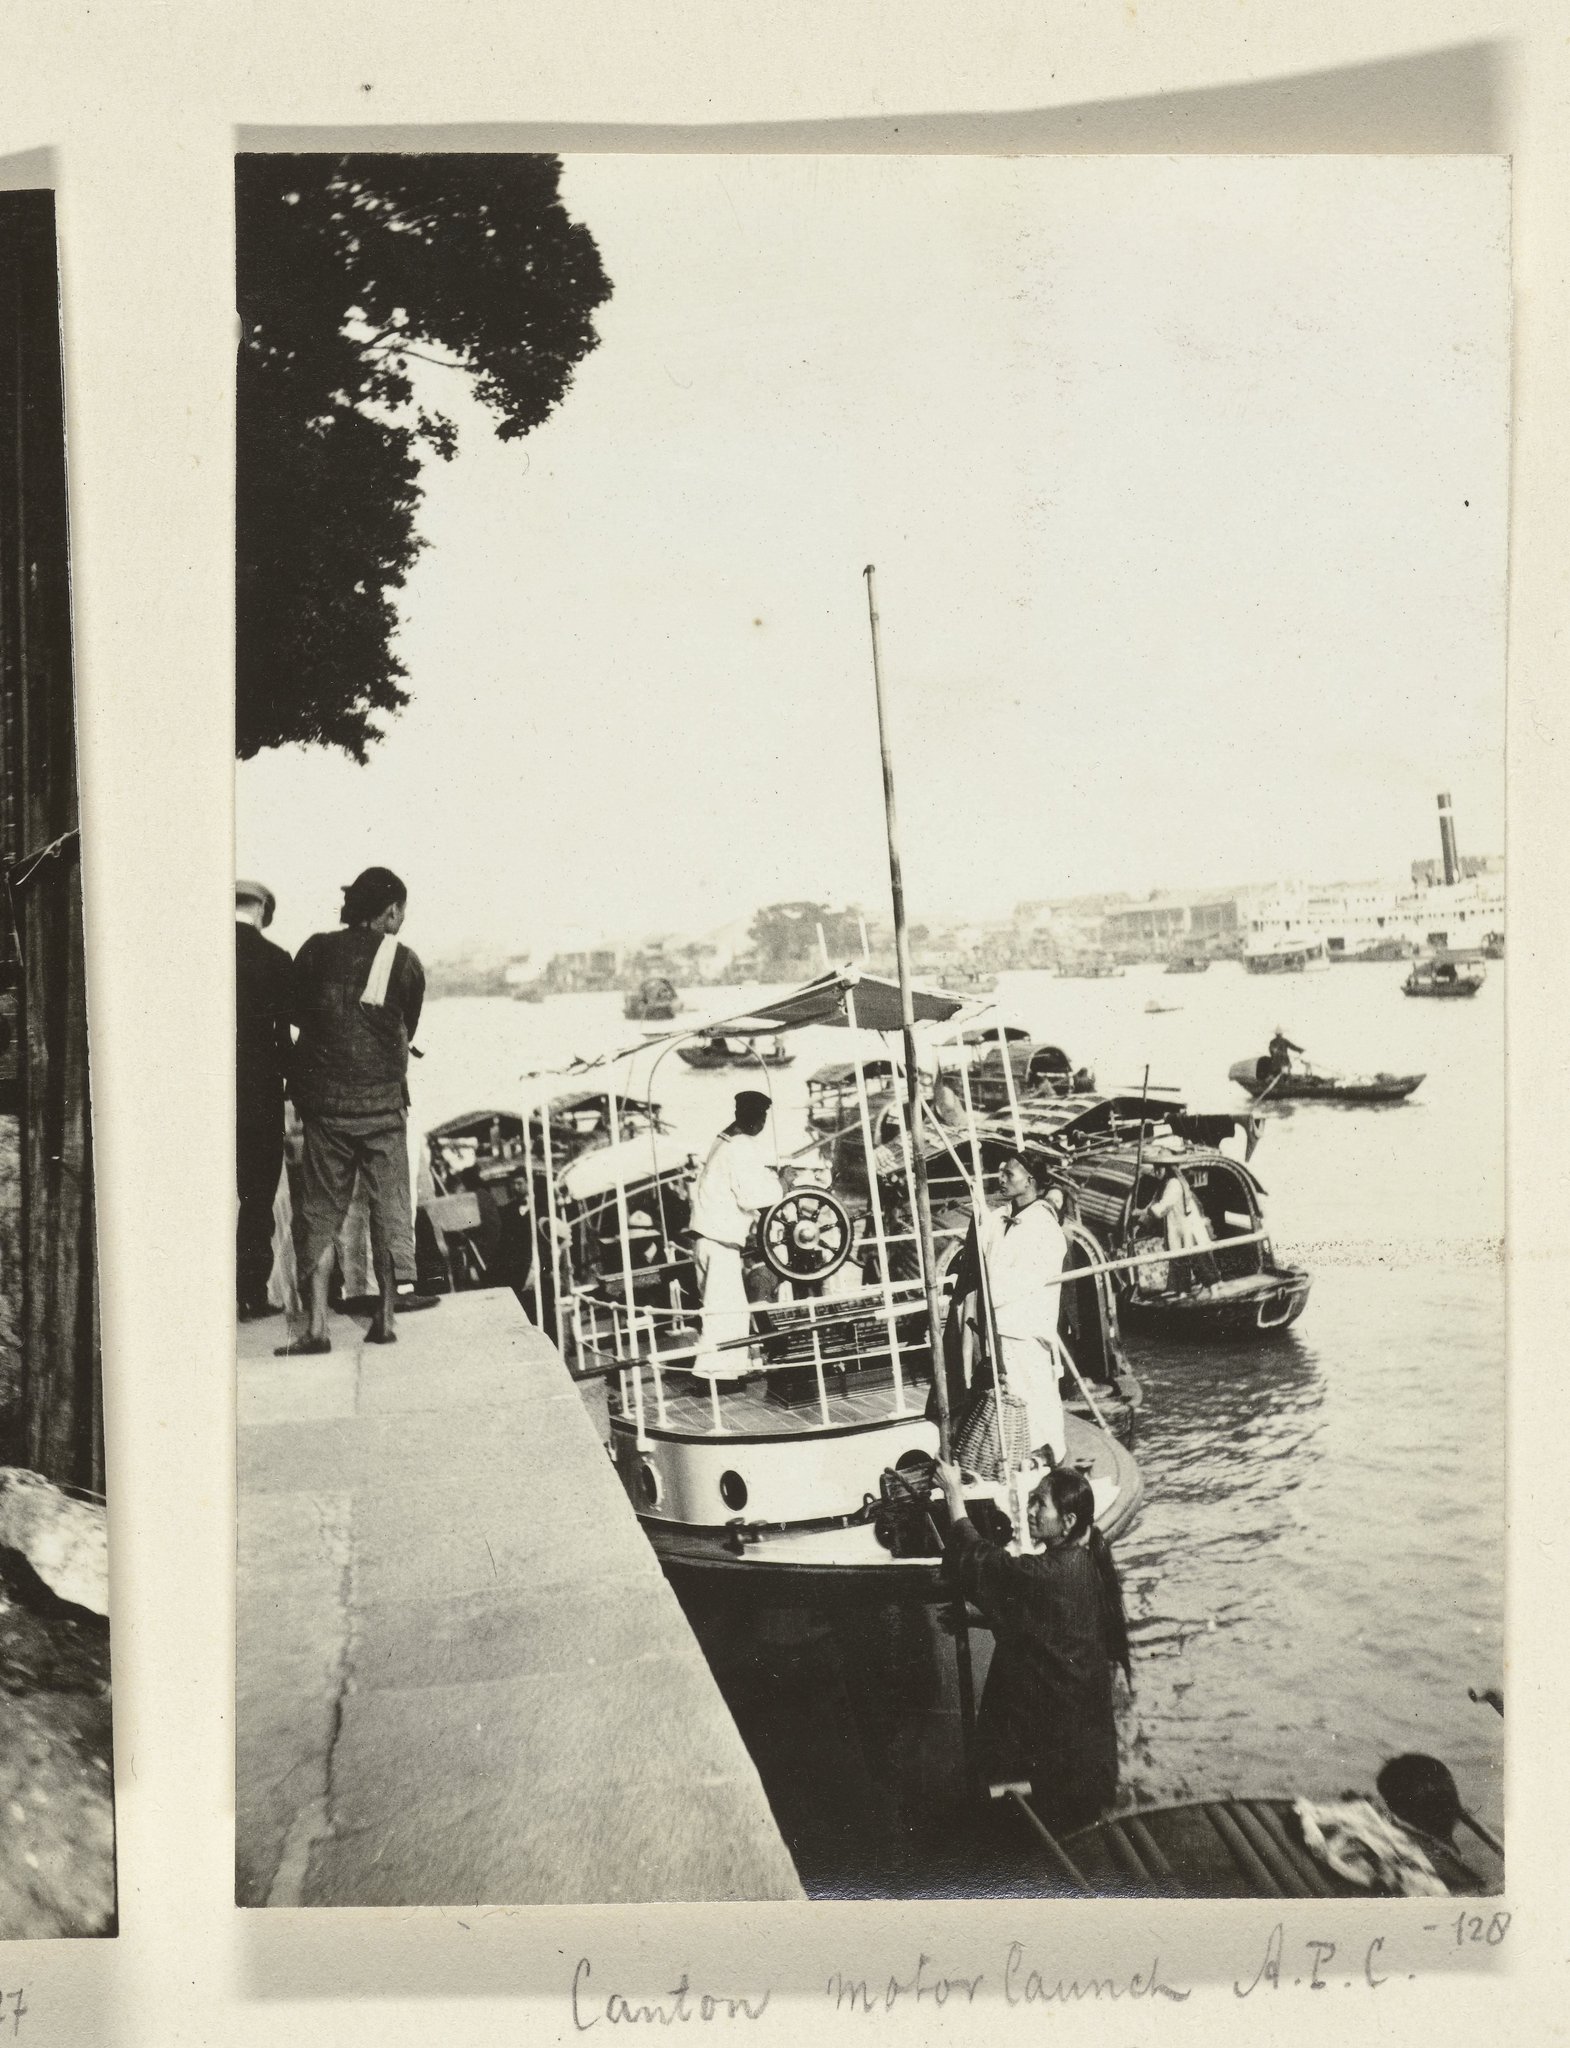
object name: photograph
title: Canton Motorlaunch A.P.C.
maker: geldolph adriaan kessler (dolph)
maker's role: fotograaf, industrieel, voetballer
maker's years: 1884-1945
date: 1903-1908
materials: cardboard, photographic support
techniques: gelatin silver print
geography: guangdong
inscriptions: title: ‘Canton, motorlaunch A.P.C.’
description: De motorboot A.P.C. ligt aangemeerd in Kanton, op de achtergrond sampans. Onderdeel van het fotoalbum van Dolph Kessler met opnamen die hij maakte tijdens zijn verblijf in Engeland en op een wereldreis die hij als secretaris van Henri Deterding (directeur Koninklijke Olie) ondernam naar Nederlands-Indië, Japan, China en de Verenigde Staten, tussen 1906 en 1908.